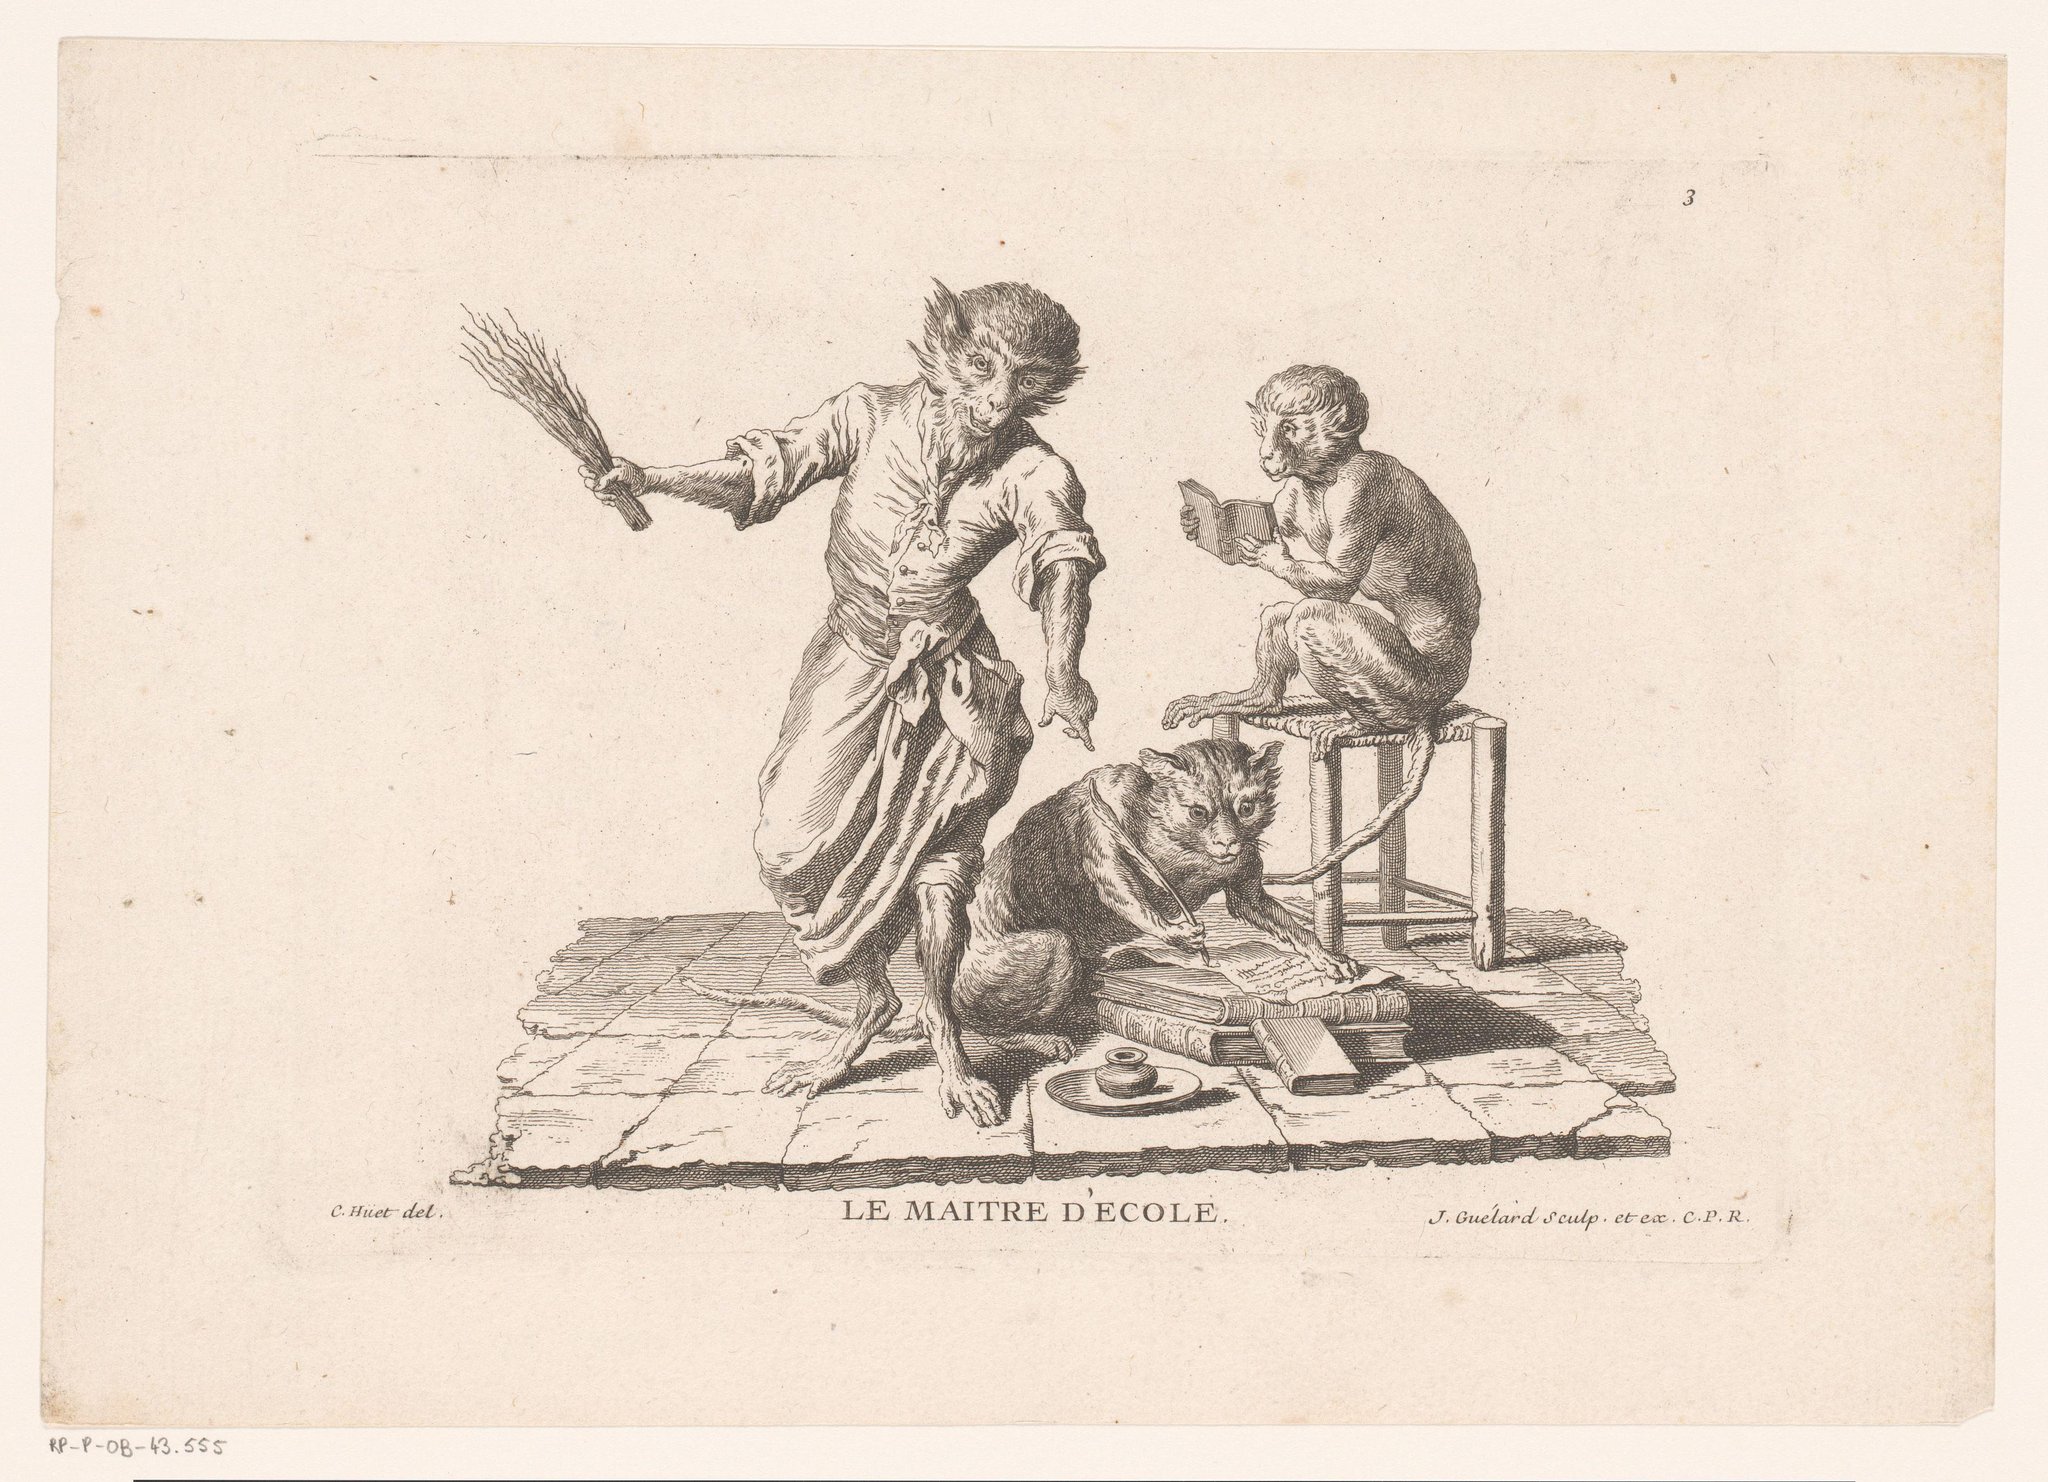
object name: print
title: Schoolmeester met leerlingen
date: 1733-1792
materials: paper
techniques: etching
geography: paris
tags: monkeys, apes, animals acting as human beings, teacher and pupil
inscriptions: collector's mark: Lugt 2228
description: Maakt deel uit van een twaalfdelige serie getiteld 'Singeries ou differentes Actions de la Vie humaine', met apenspelen. De serie bestaat uit twee delen met elk twaalf platen en een opdracht. Deze serie is opgedragen aan het publiek (Au Public). Het andere deel werd opgedragen aan Monsieur de l'Orme van de Ménagerie de Versailles. De serie werd initieel uitgegeven door Guélard en de weduwe van Chéreau. Dit betreft waarschijnlijk een door het IFF onbeschreven latere staat, uitgegeven door Étienne Charpentier.